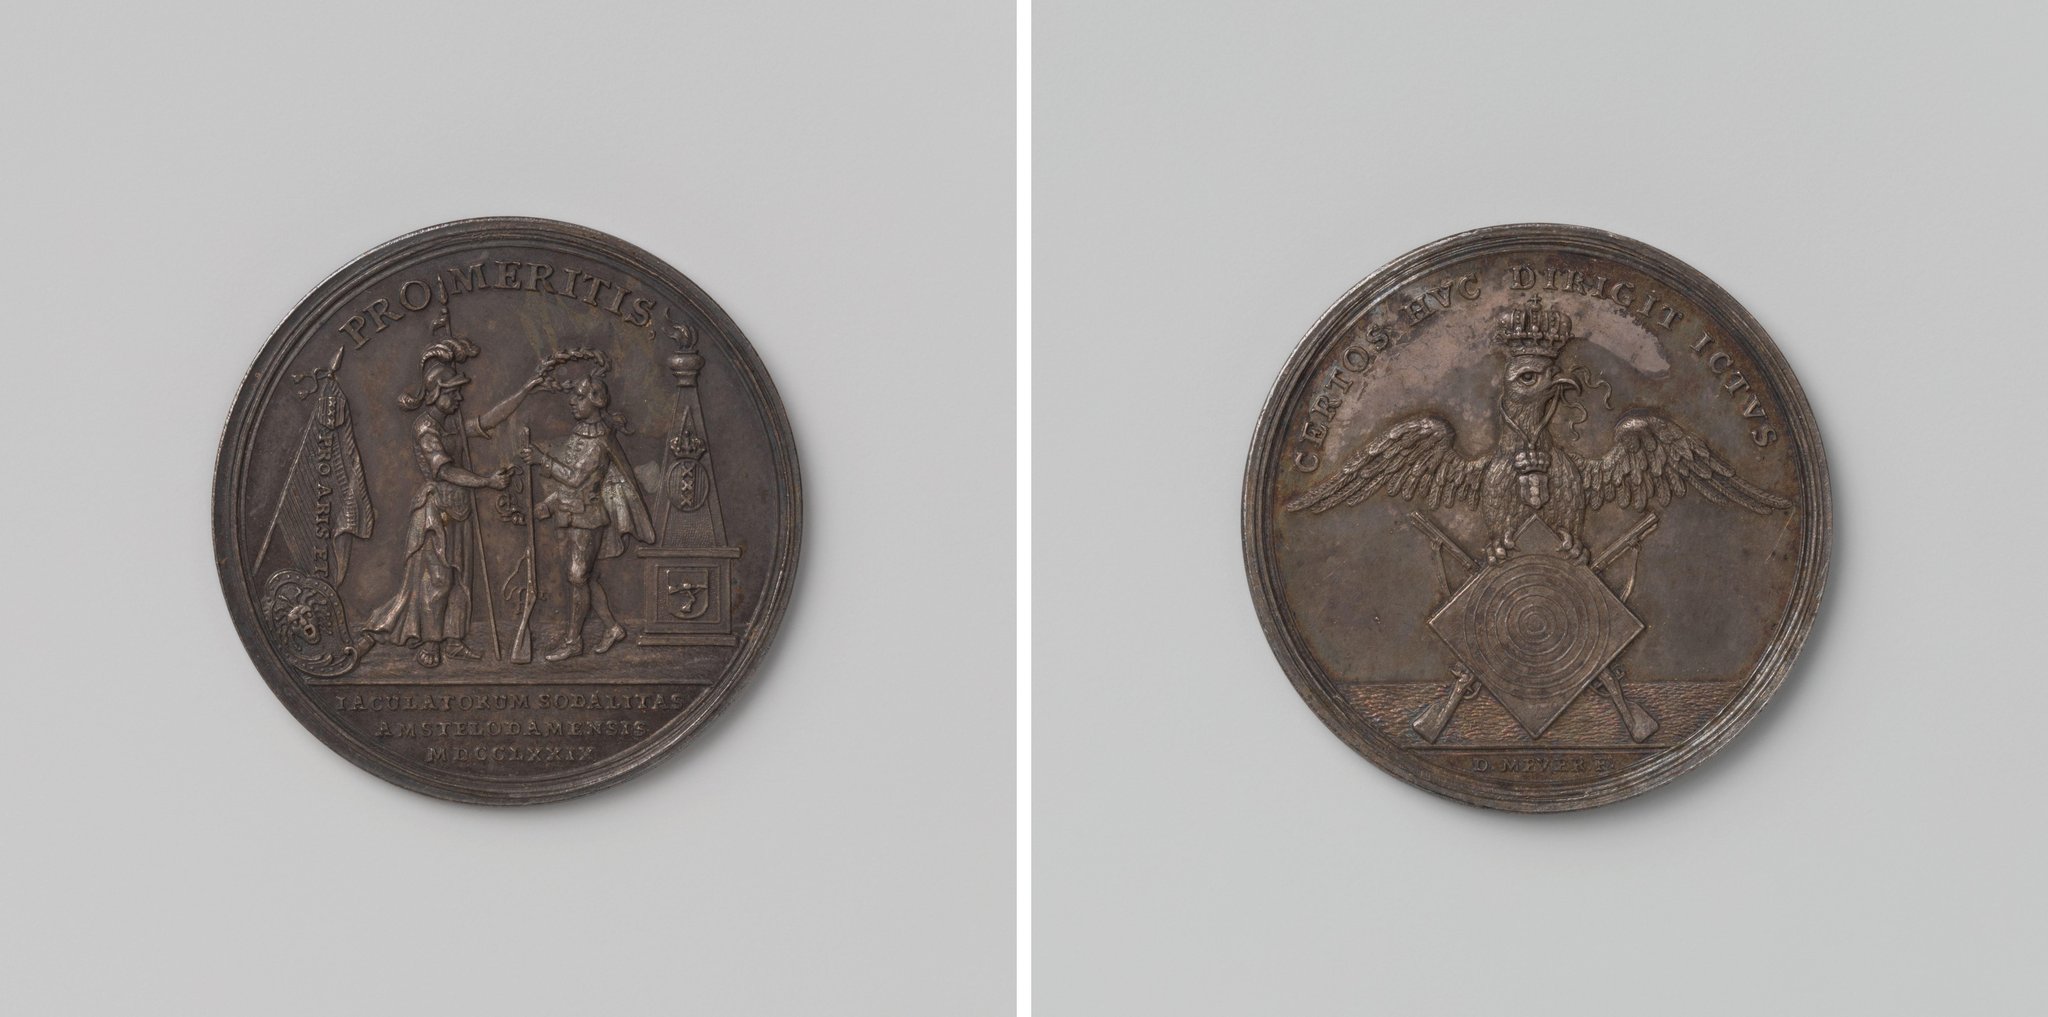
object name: marksman medal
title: Schuttersgezelschap van Amsterdam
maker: hendrik de meijer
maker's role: die cutter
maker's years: 1766-1789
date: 1779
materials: silver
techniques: striking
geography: amsterdam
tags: amsterdam